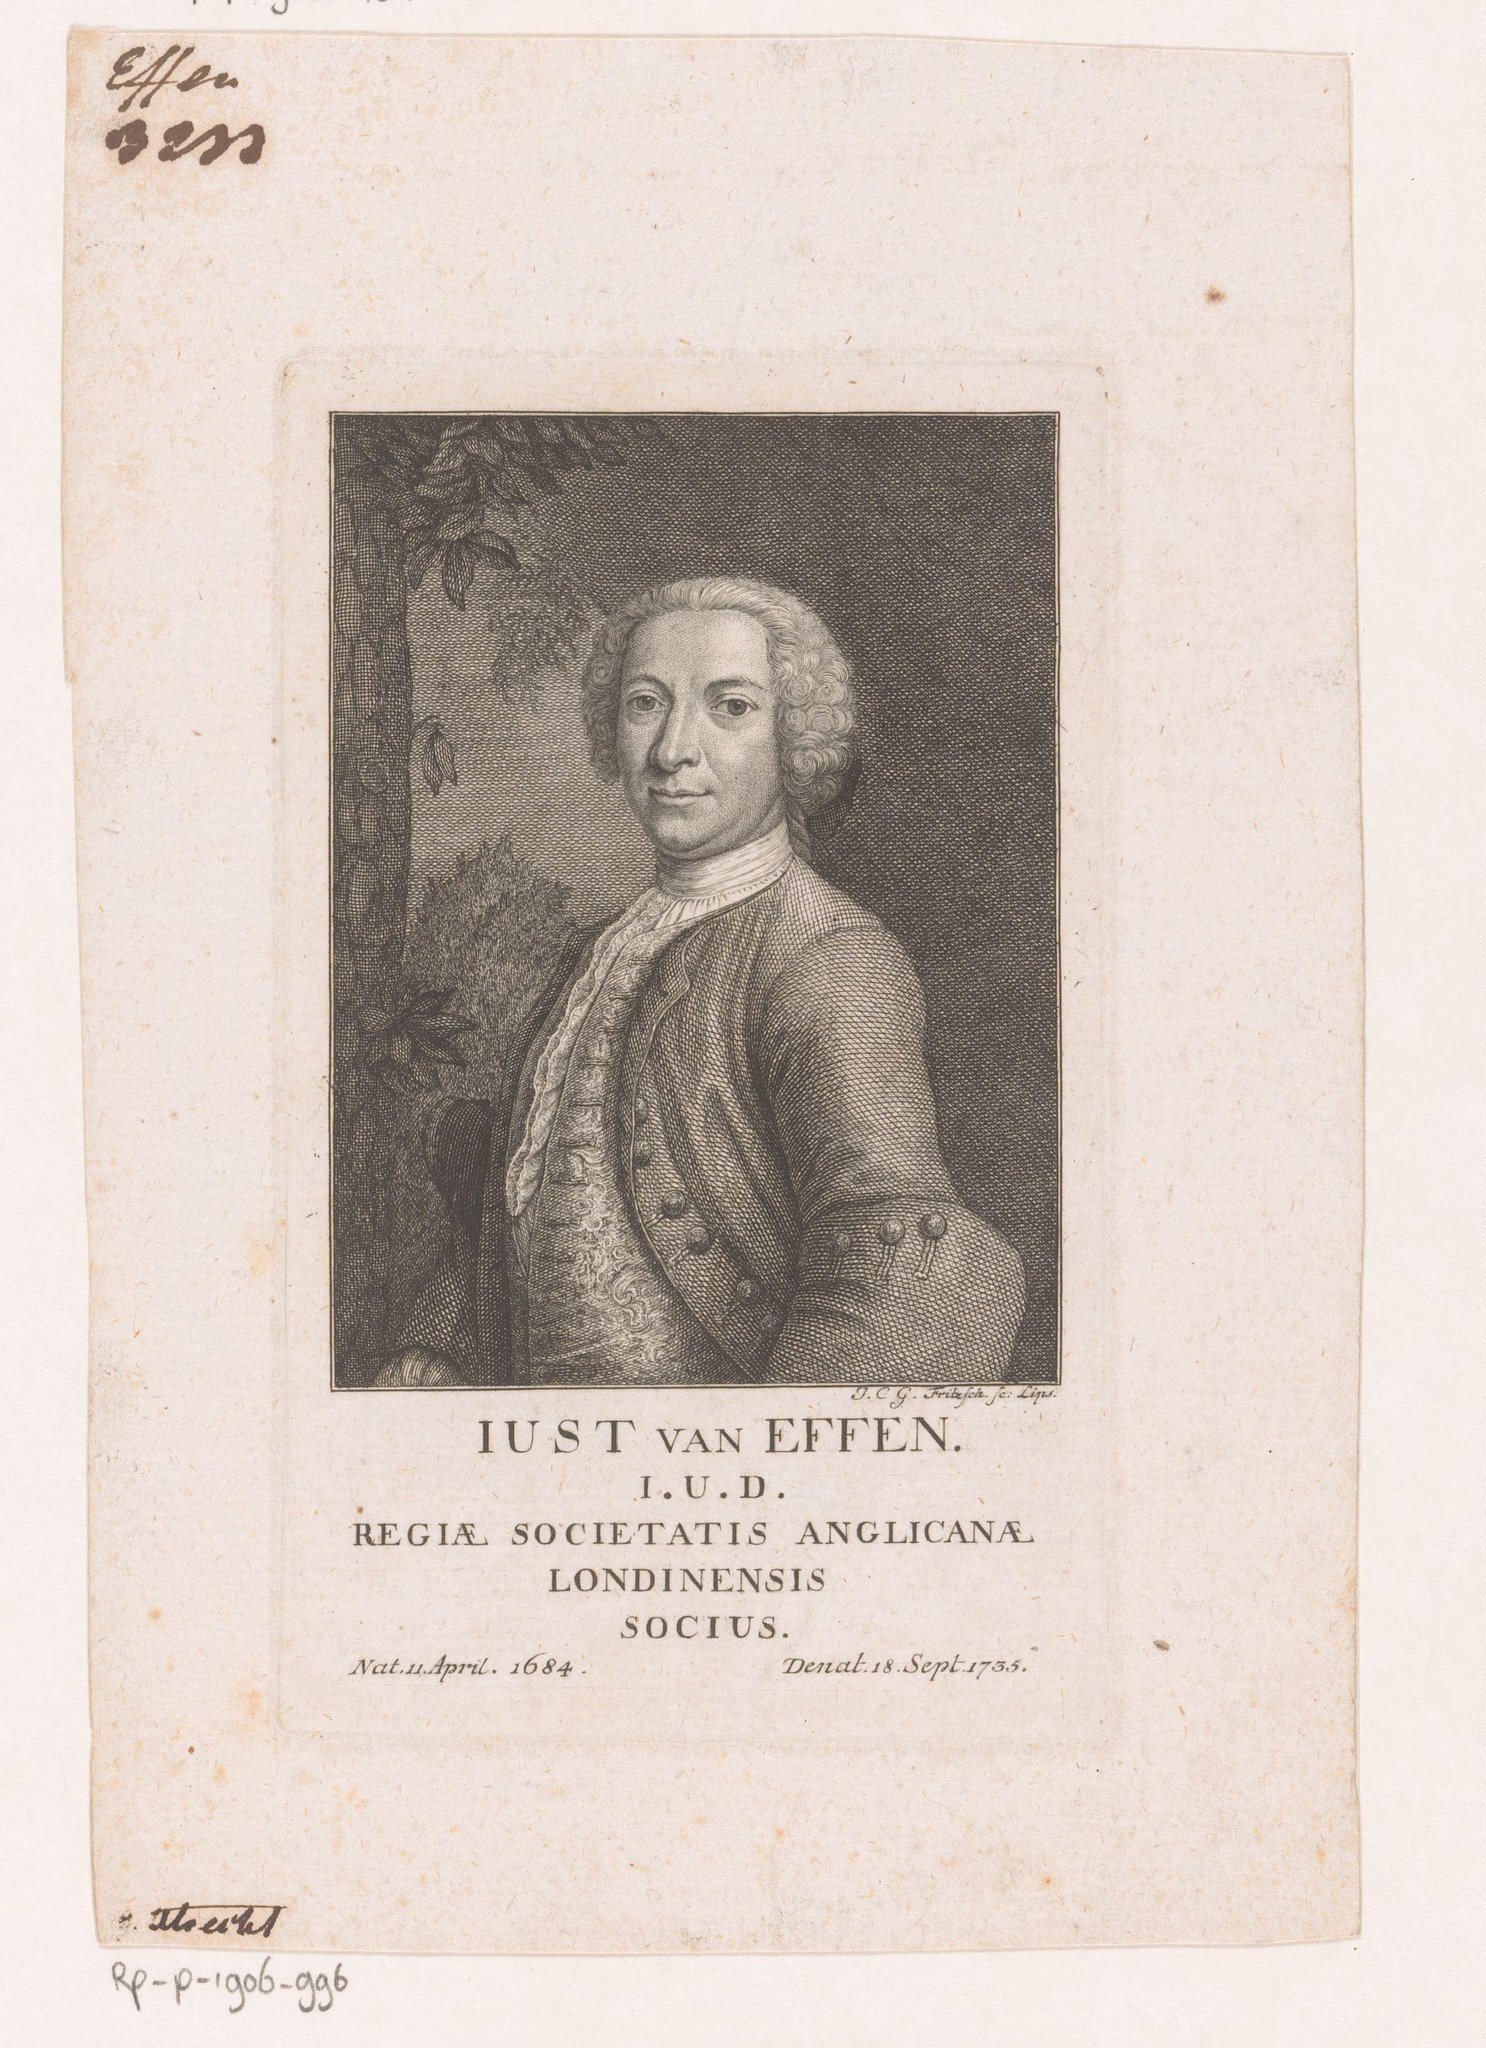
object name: print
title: Portret van Justus van Effen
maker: johann christian gottfried fritzsch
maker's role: print maker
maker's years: 1720-1802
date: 1735-1802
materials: paper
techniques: engraving, etching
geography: leipzig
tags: utrecht, den bosch, historical persons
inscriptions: collector's mark: Lugt 2228